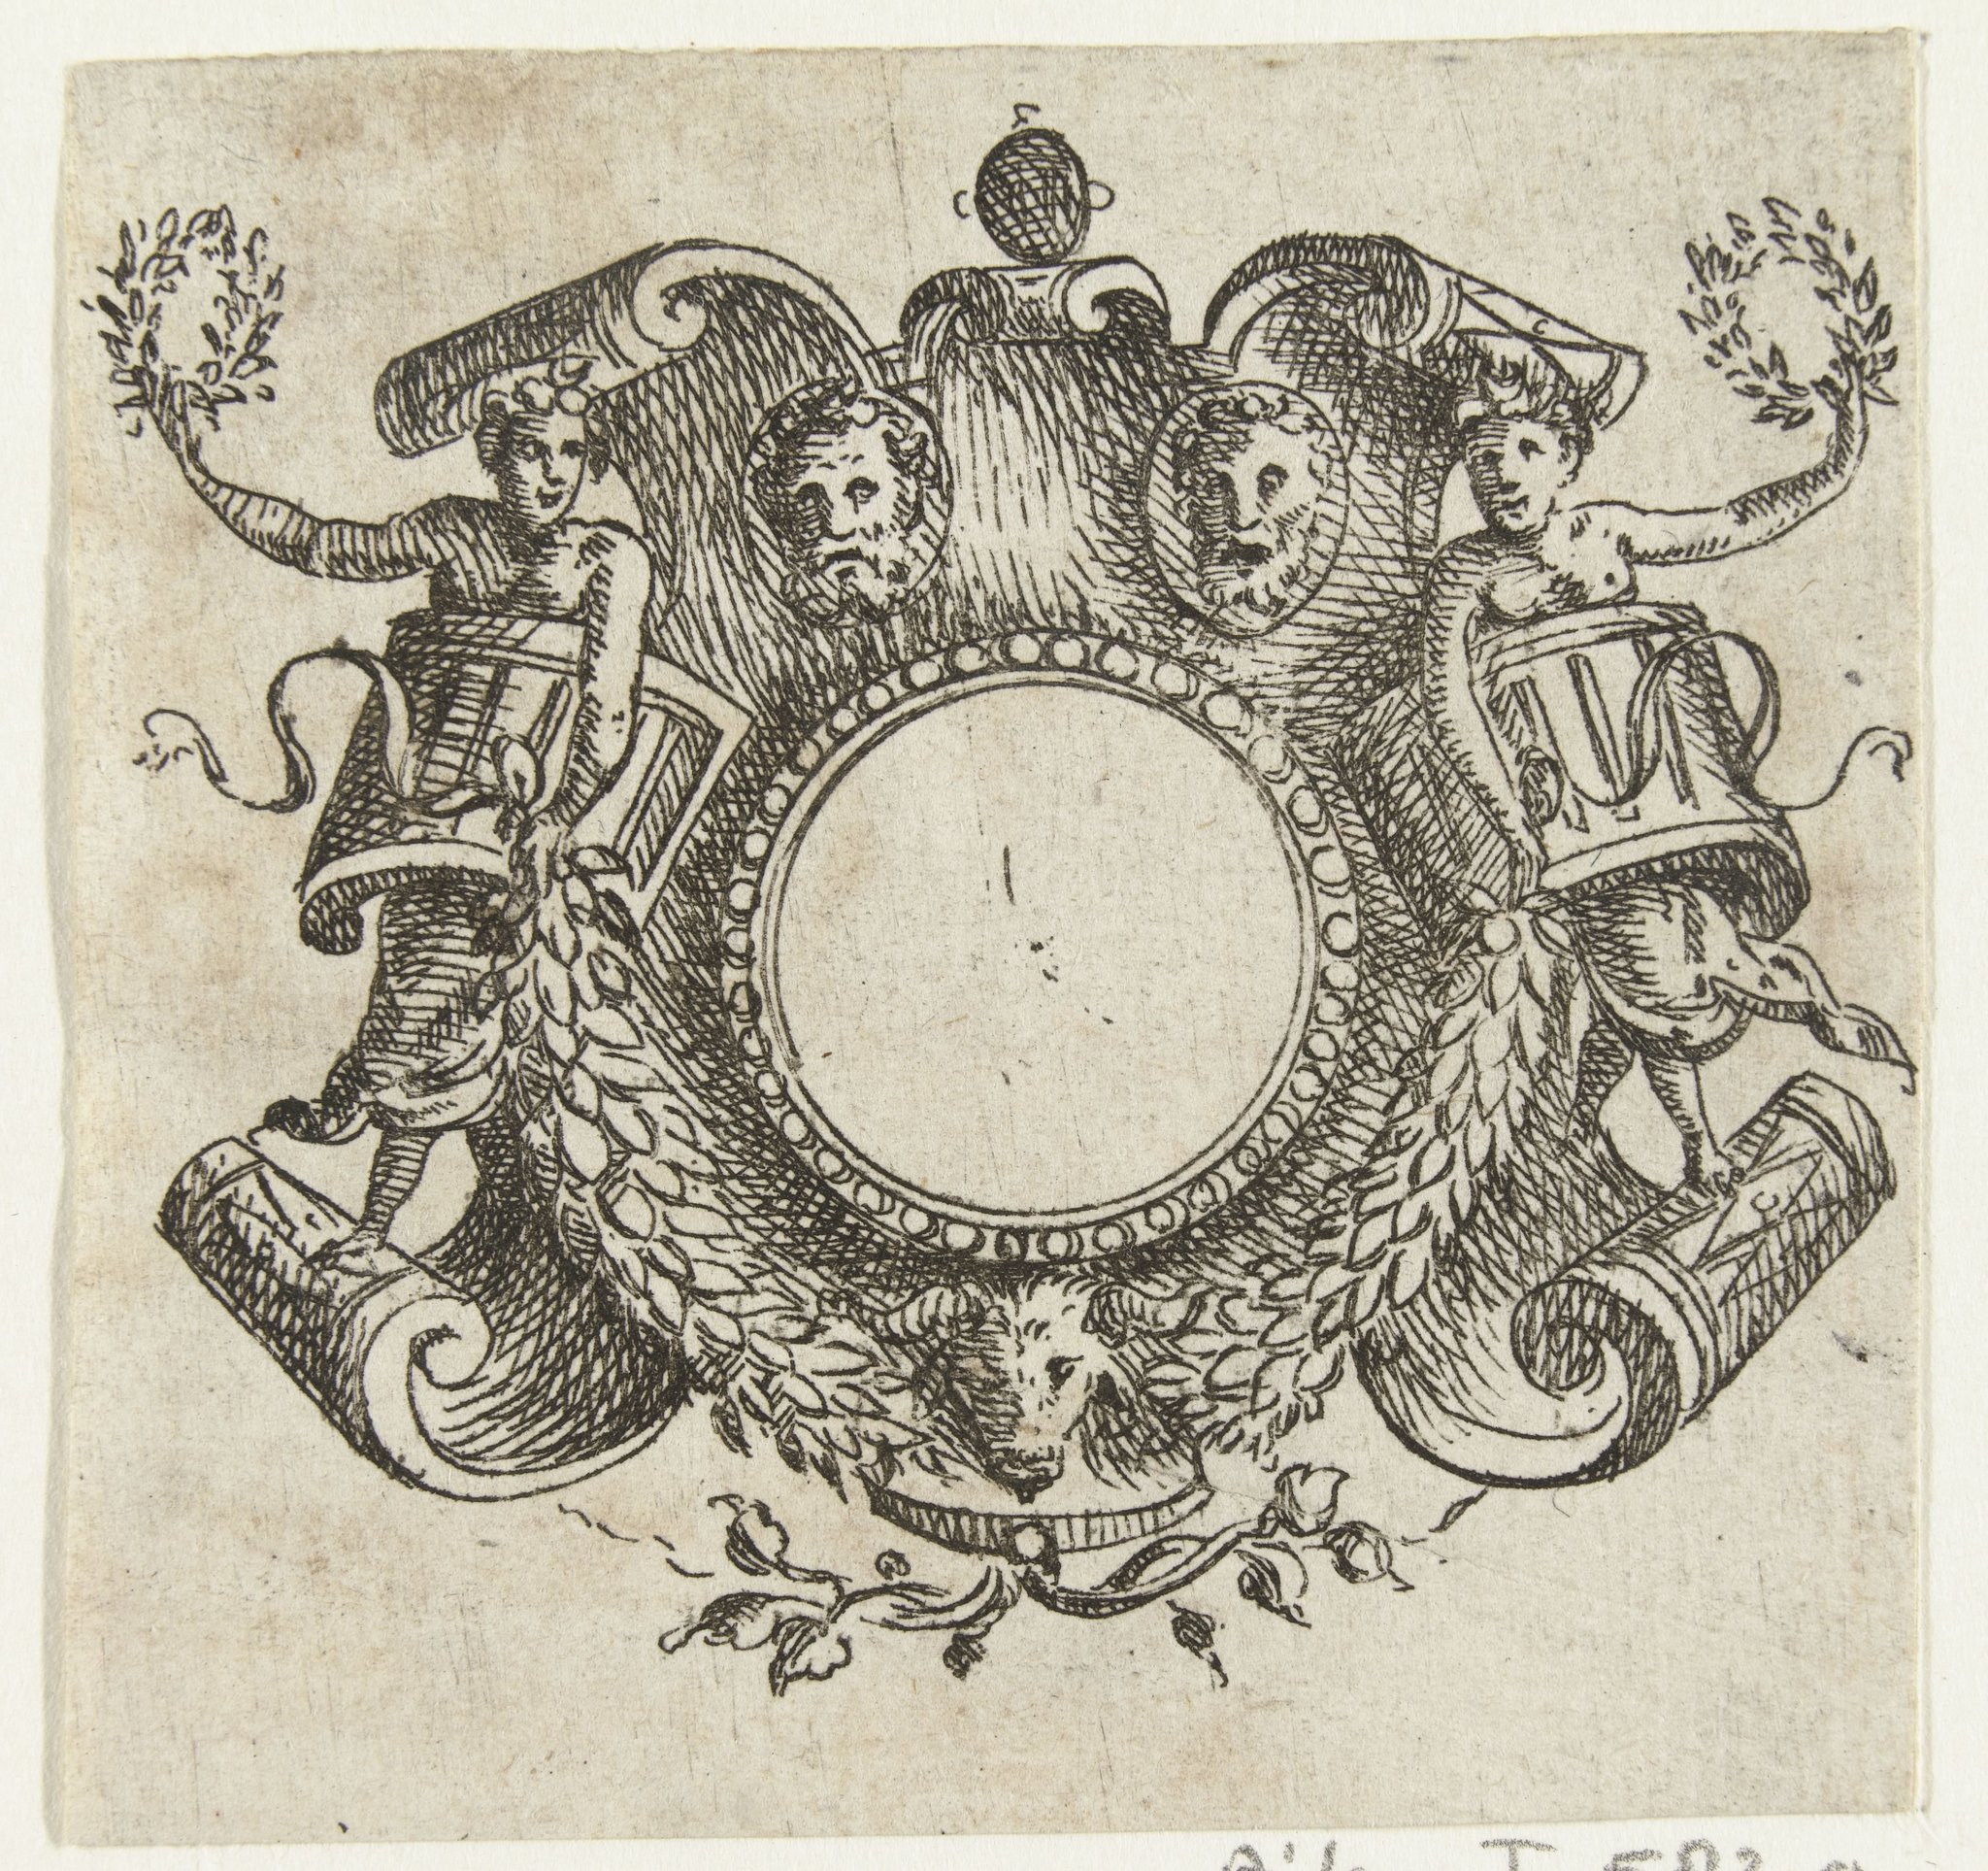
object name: ornament print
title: Ronde cartouche tussen een vrouwelijke en een mannelijke sater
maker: Anonymous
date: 1500-1600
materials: paper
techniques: etching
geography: france